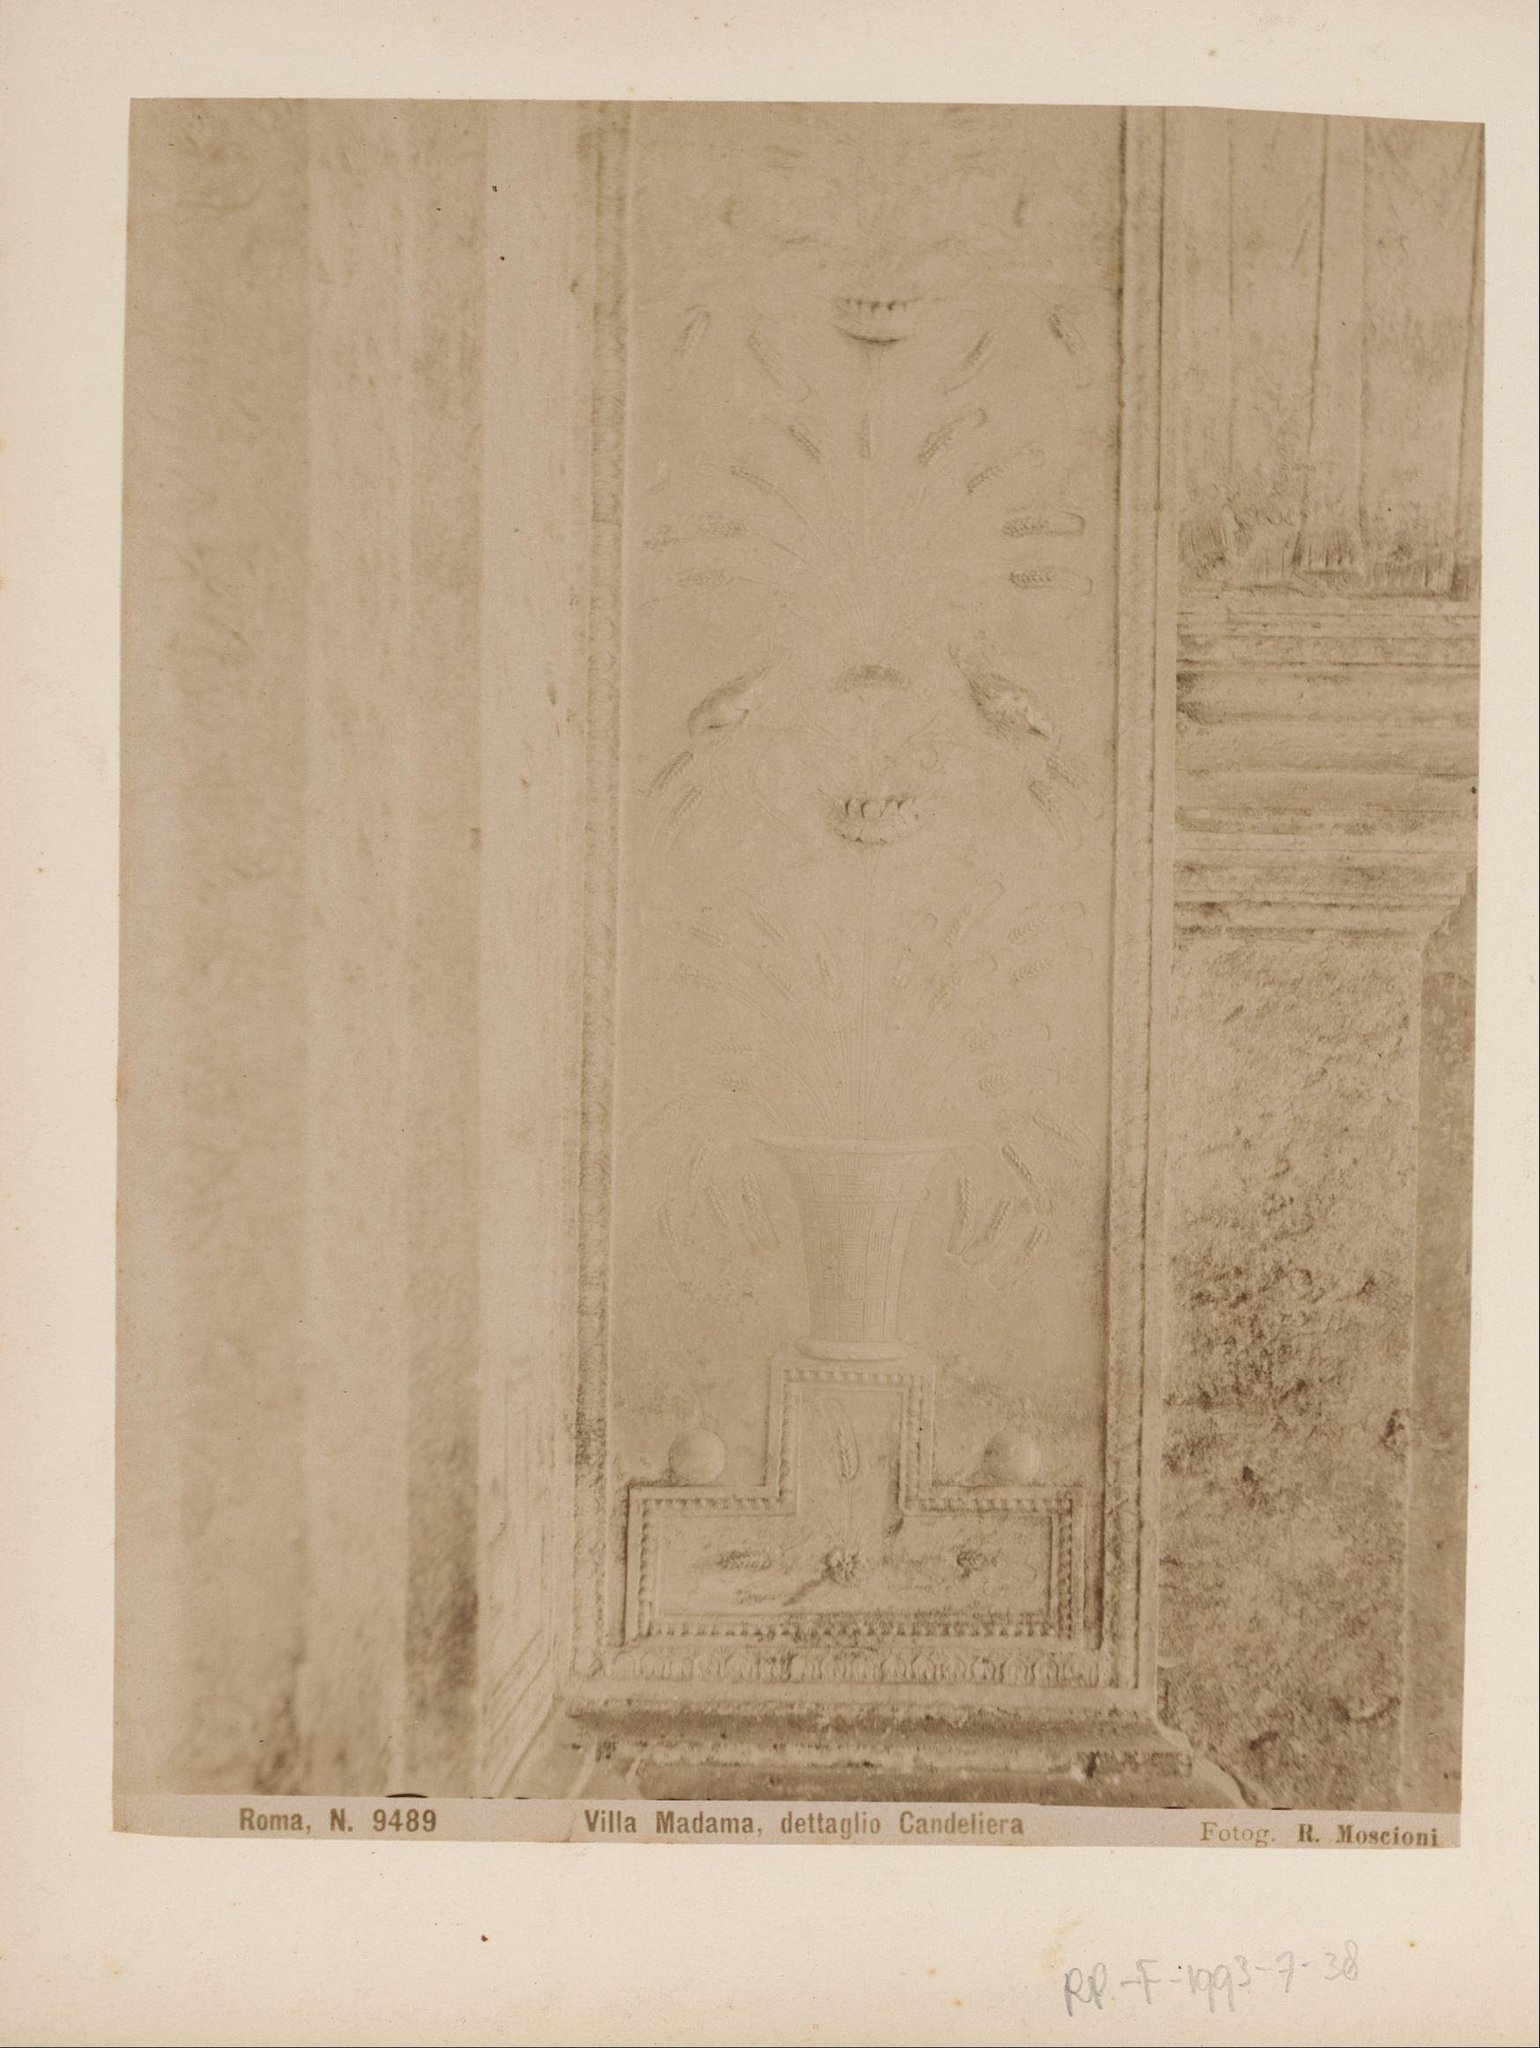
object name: album leaf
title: Roma, N. 9489 Villa Madama, dettaglio Candeliera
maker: romualdo moscioni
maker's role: fotograaf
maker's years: 1849-1925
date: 1868-1900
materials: paper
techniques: albumen print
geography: rome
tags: rural housing, e.g. country-house, villa, cottage, piece of sculpture, reproduction of a piece of sculpture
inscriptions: inscription: ‘Roma, N. 9489 Villa Madama, dettaglio Candeliera Fotog. R. Moscioni’